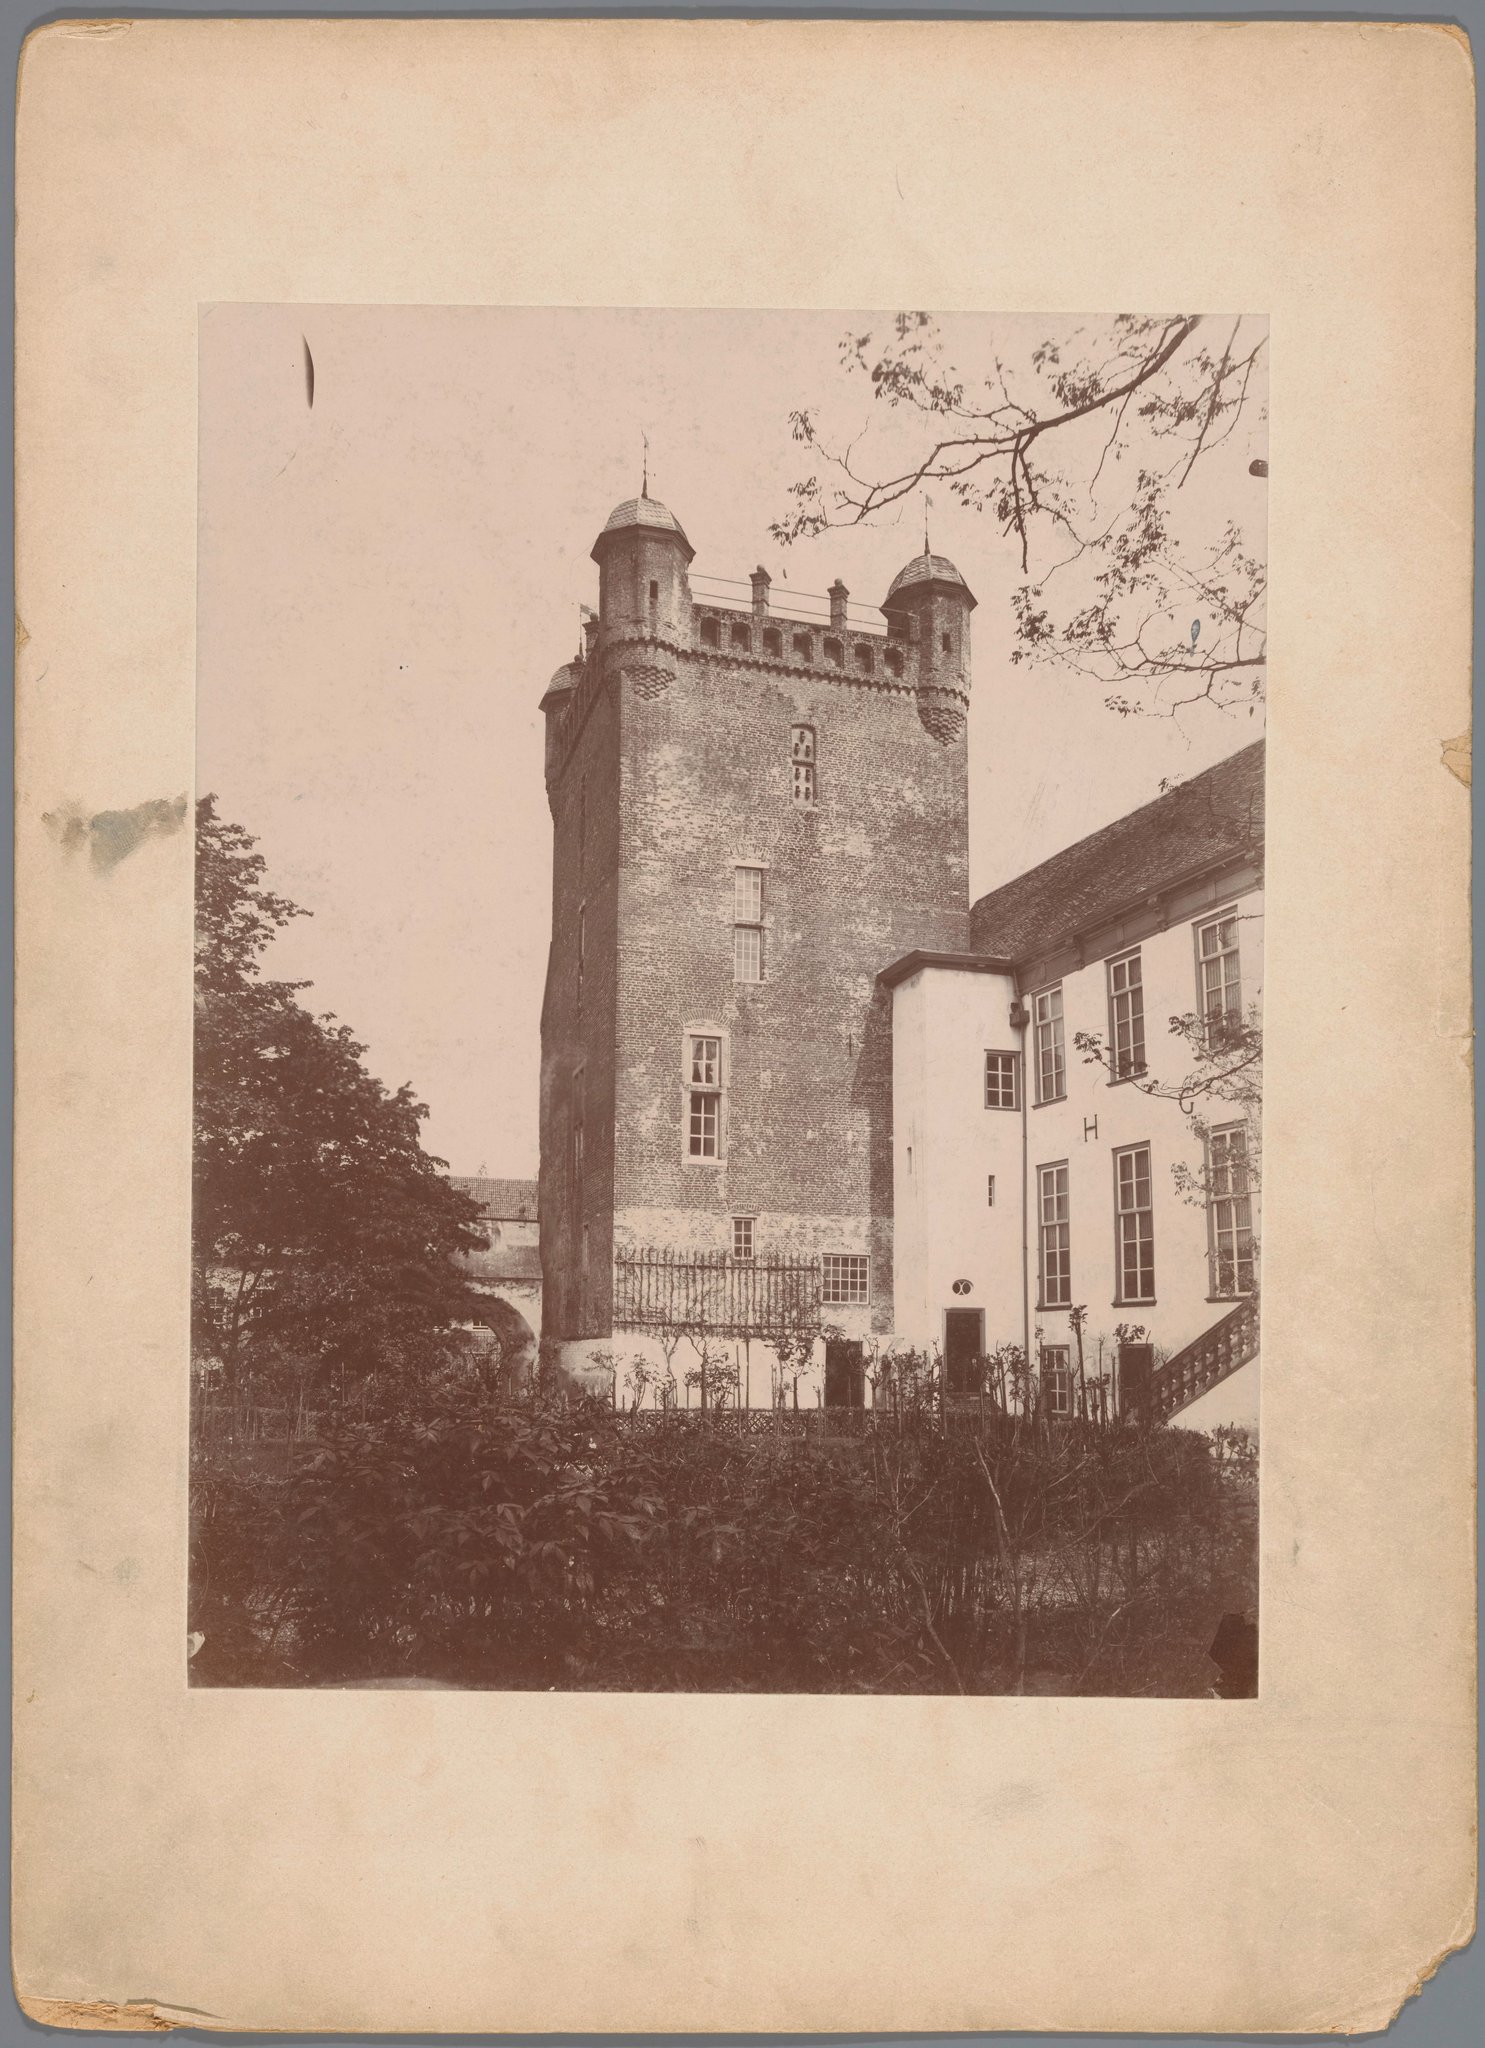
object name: photograph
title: Gezicht op de toren van Huis Bergh te 's-Heerenberg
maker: Anonymous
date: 1875-1900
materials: cardboard, photographic support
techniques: daylight paper print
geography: s-heerenberg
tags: tower, clock tower ~ monumental adornment, castle, façade (of house or building)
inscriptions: collector's mark: Lugt 3937, inscription: ‘Kasteel te s Heerenberg. Toren’